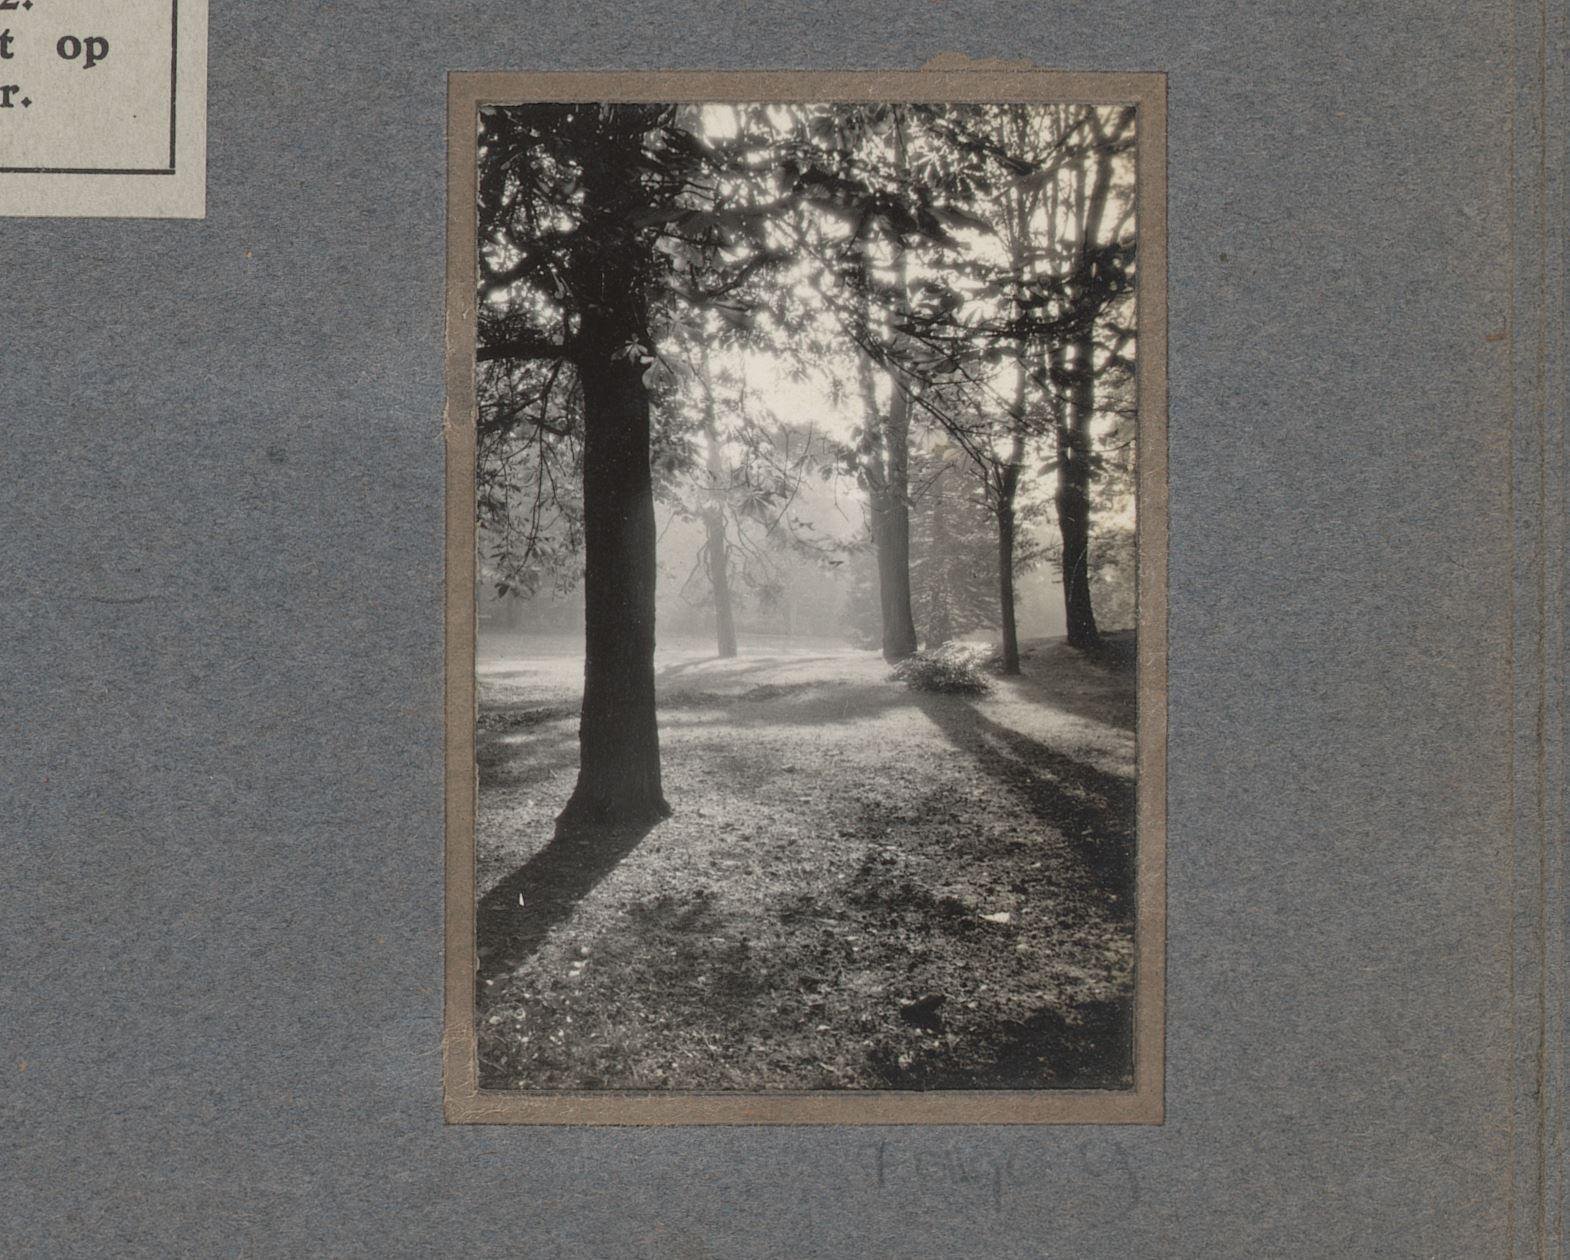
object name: photograph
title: Bosgezicht met nevel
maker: Anonymous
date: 1924-1931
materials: photographic support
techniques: gelatin silver print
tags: forest, wood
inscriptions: inscription: ‘Opnamen gemaakt met de "Brownie"No. 2./ Afdrukken gemaakt op "Velox" papier.’